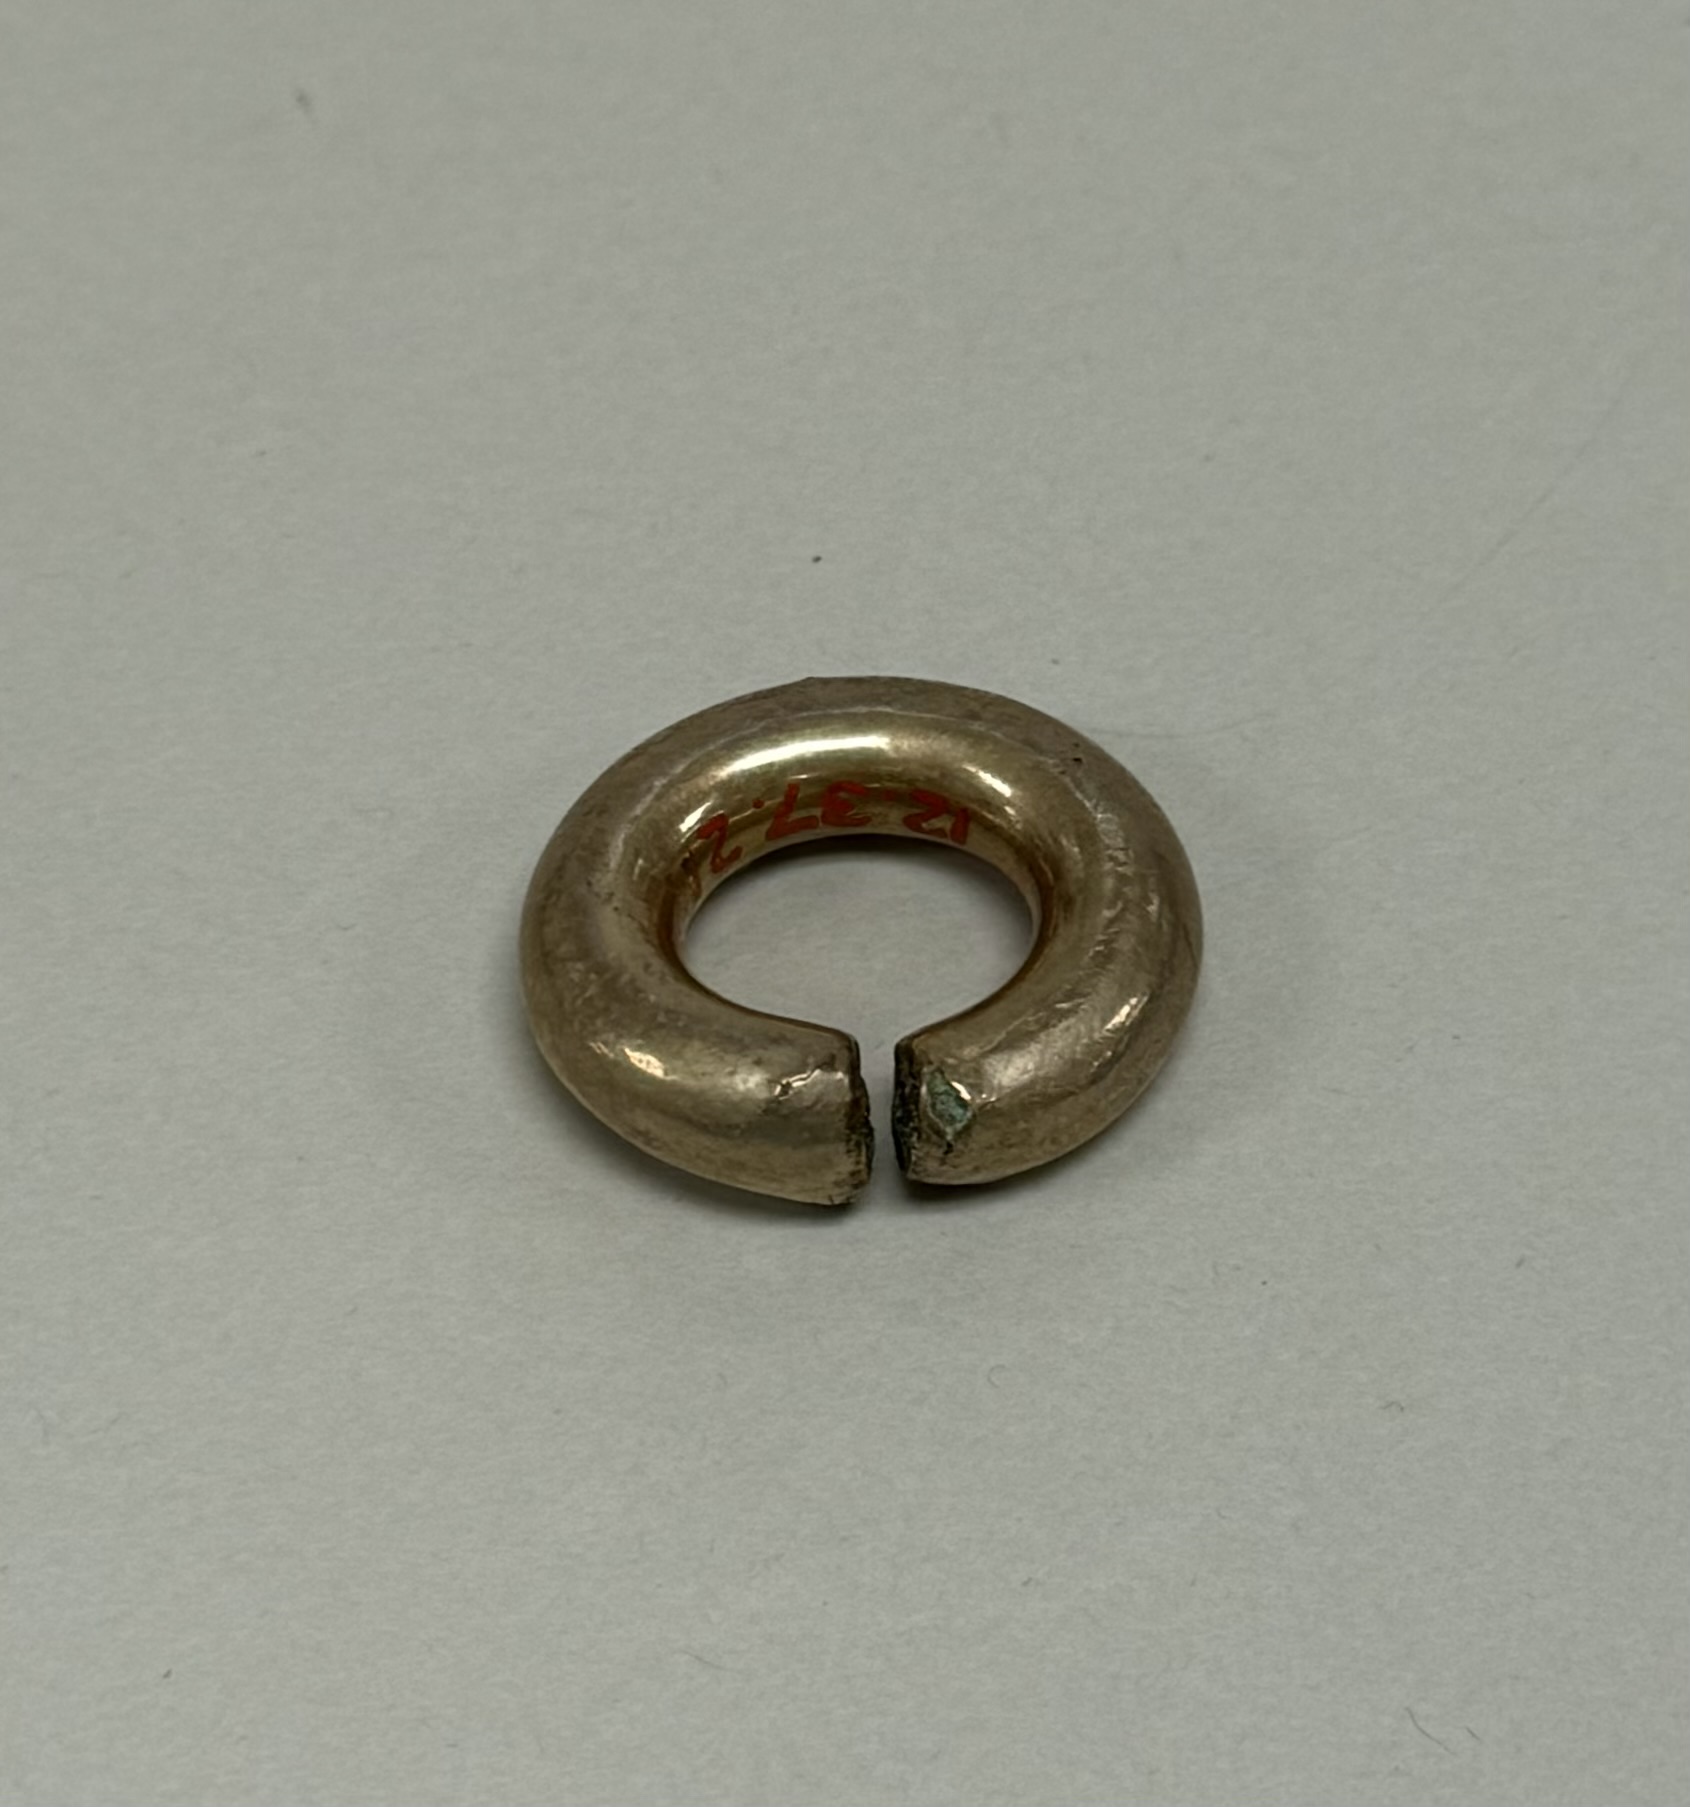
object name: earring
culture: japanese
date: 601-700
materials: metal